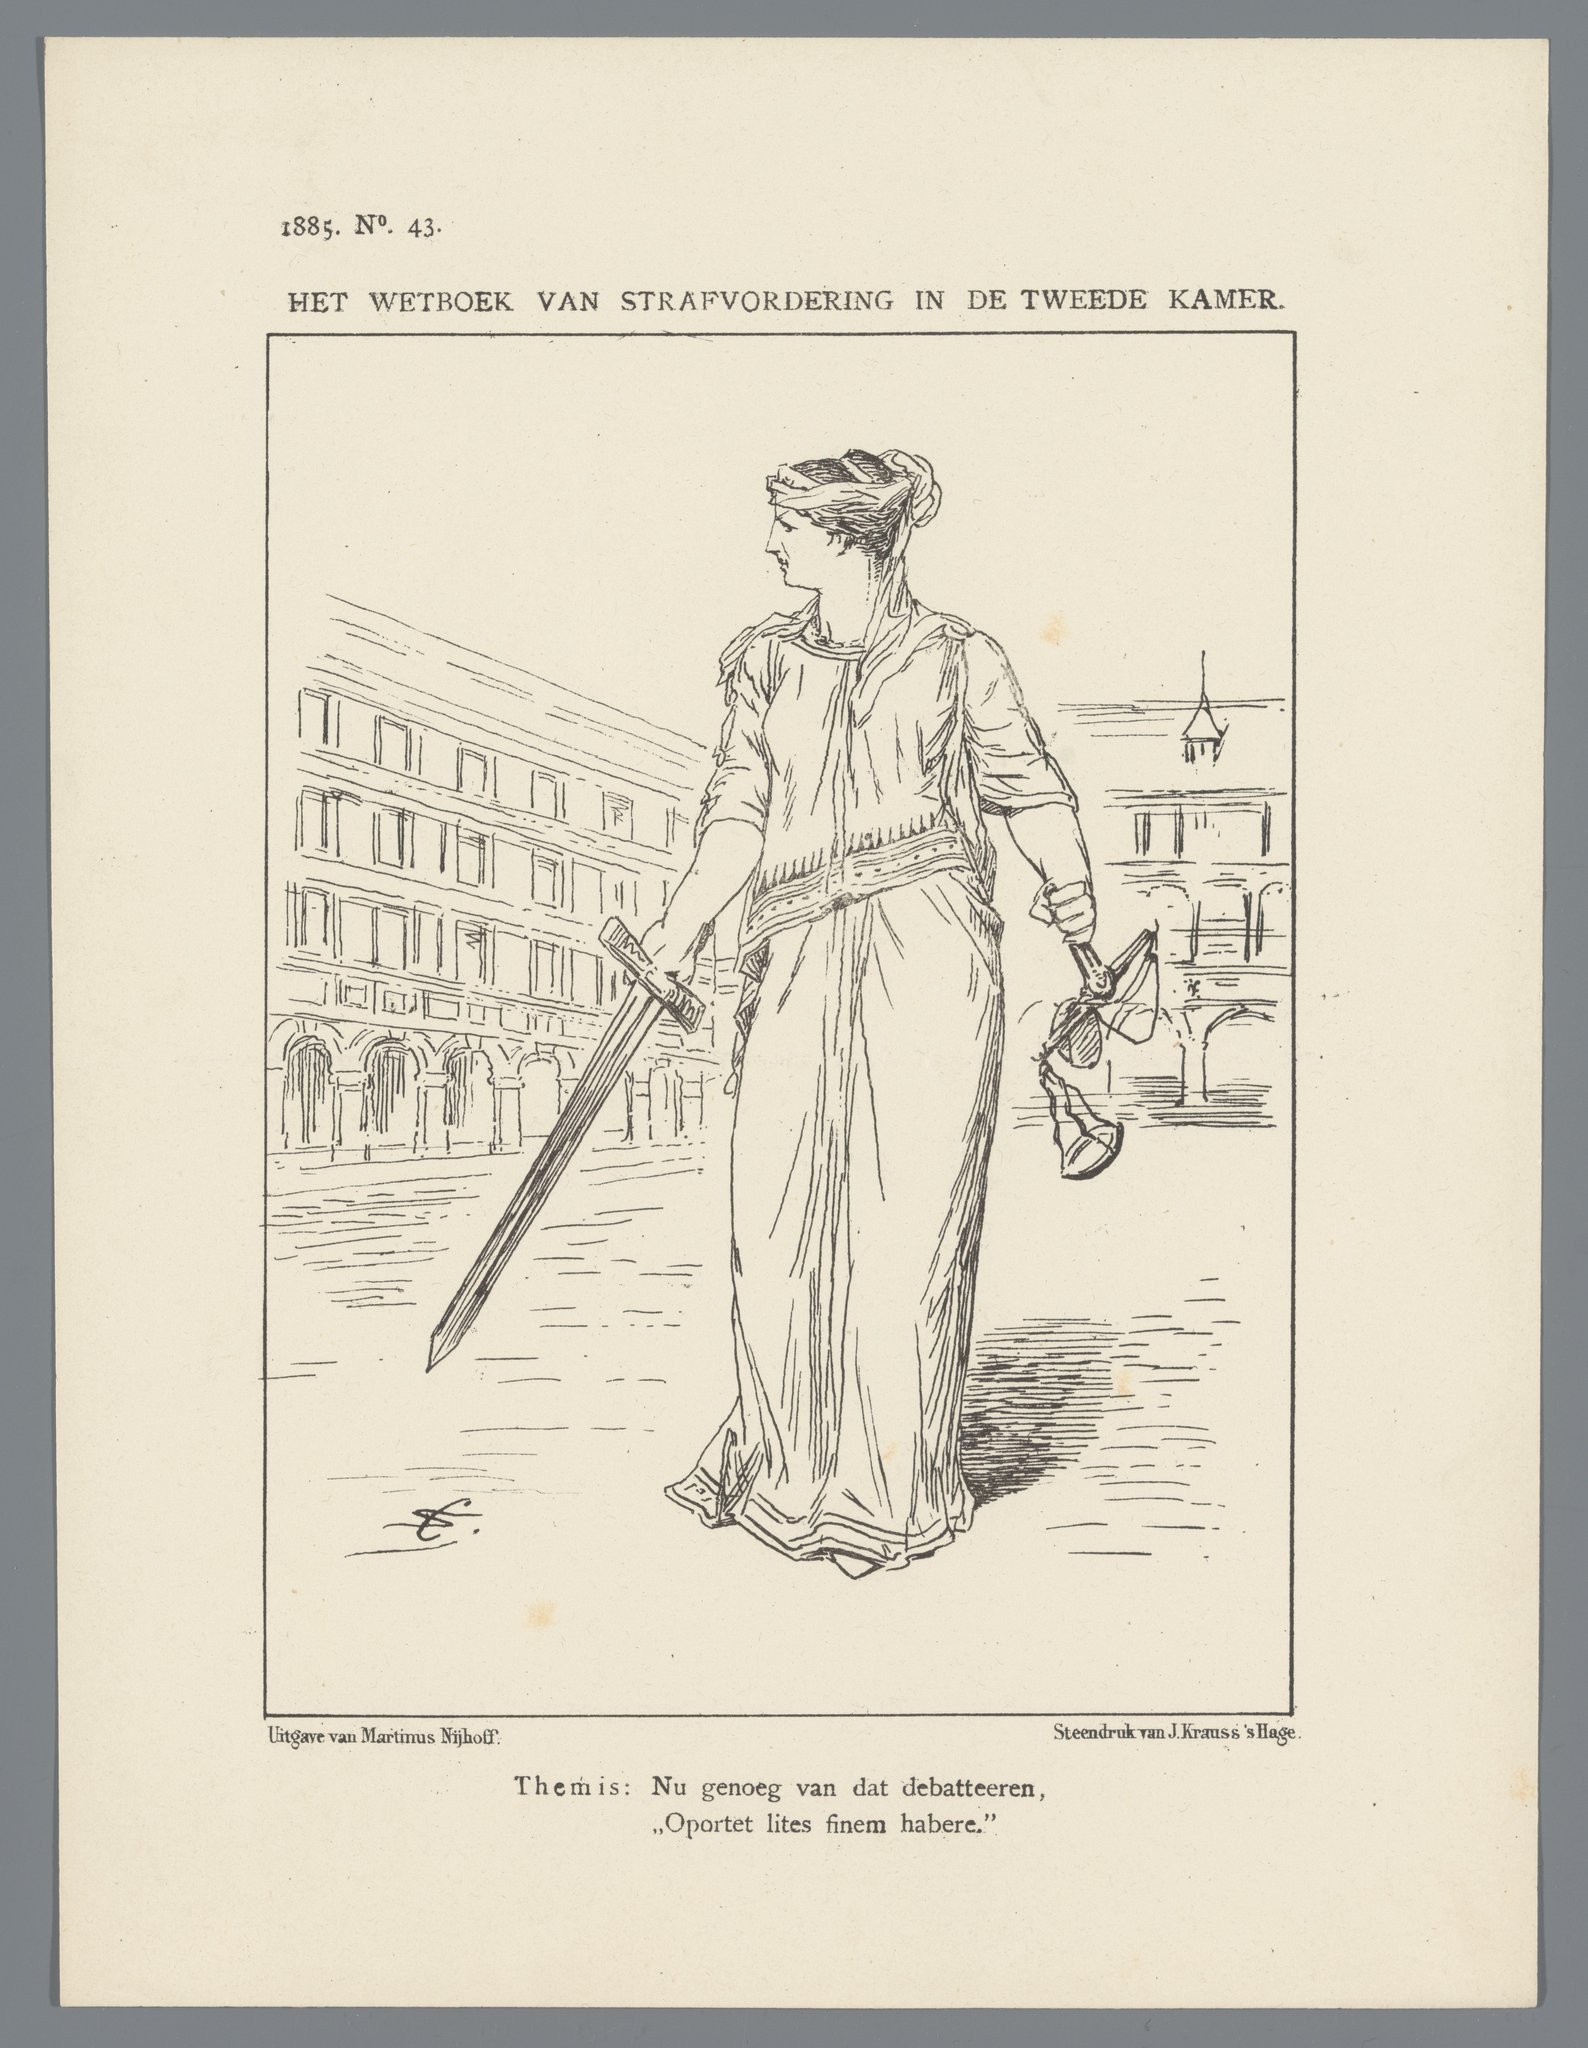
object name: cartoon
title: Het wetboek van strafvordering in de Tweede Kamer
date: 1885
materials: paper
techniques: lithograph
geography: the hague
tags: justice, 'justitia'; 'giustitia divina' (ripa) ~ one of the four cardinal virtues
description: Spotprent met Themis op het Binnenhof, 1885. Plaat verschenen bij het weekblad De Nederlandsche Spectator, nr. 43, 1885.